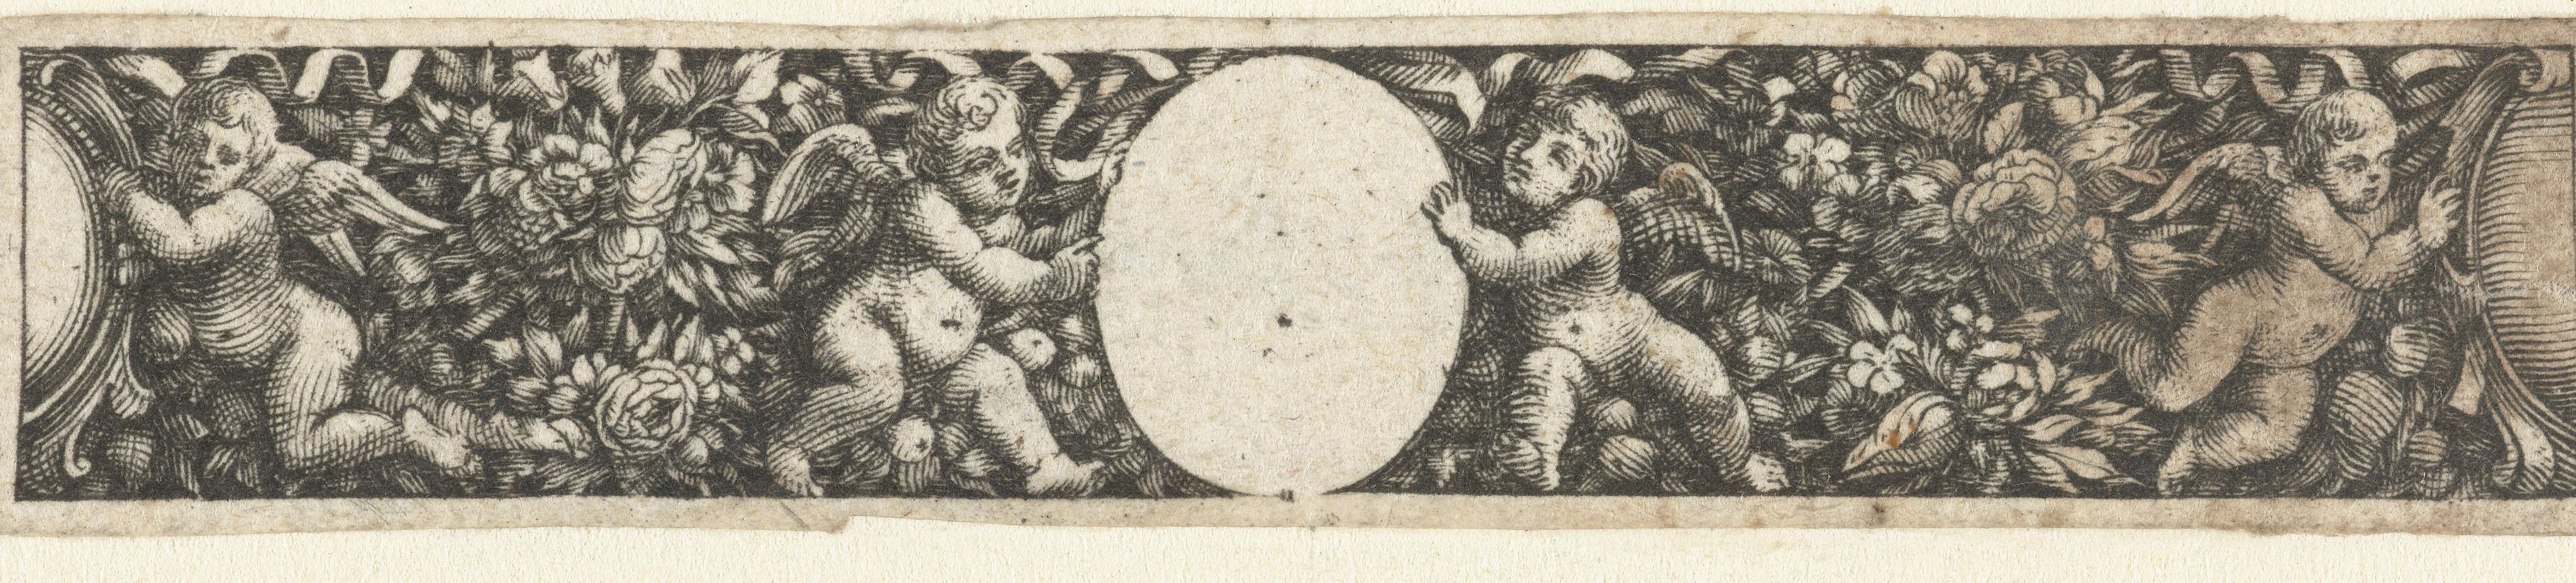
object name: ornament print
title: Strook met vier putti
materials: paper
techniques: engraving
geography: france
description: In het midden staan twee putti aan weerszijden van een ovaal met op de achtergrond een dubbele guirlande van bloemen.